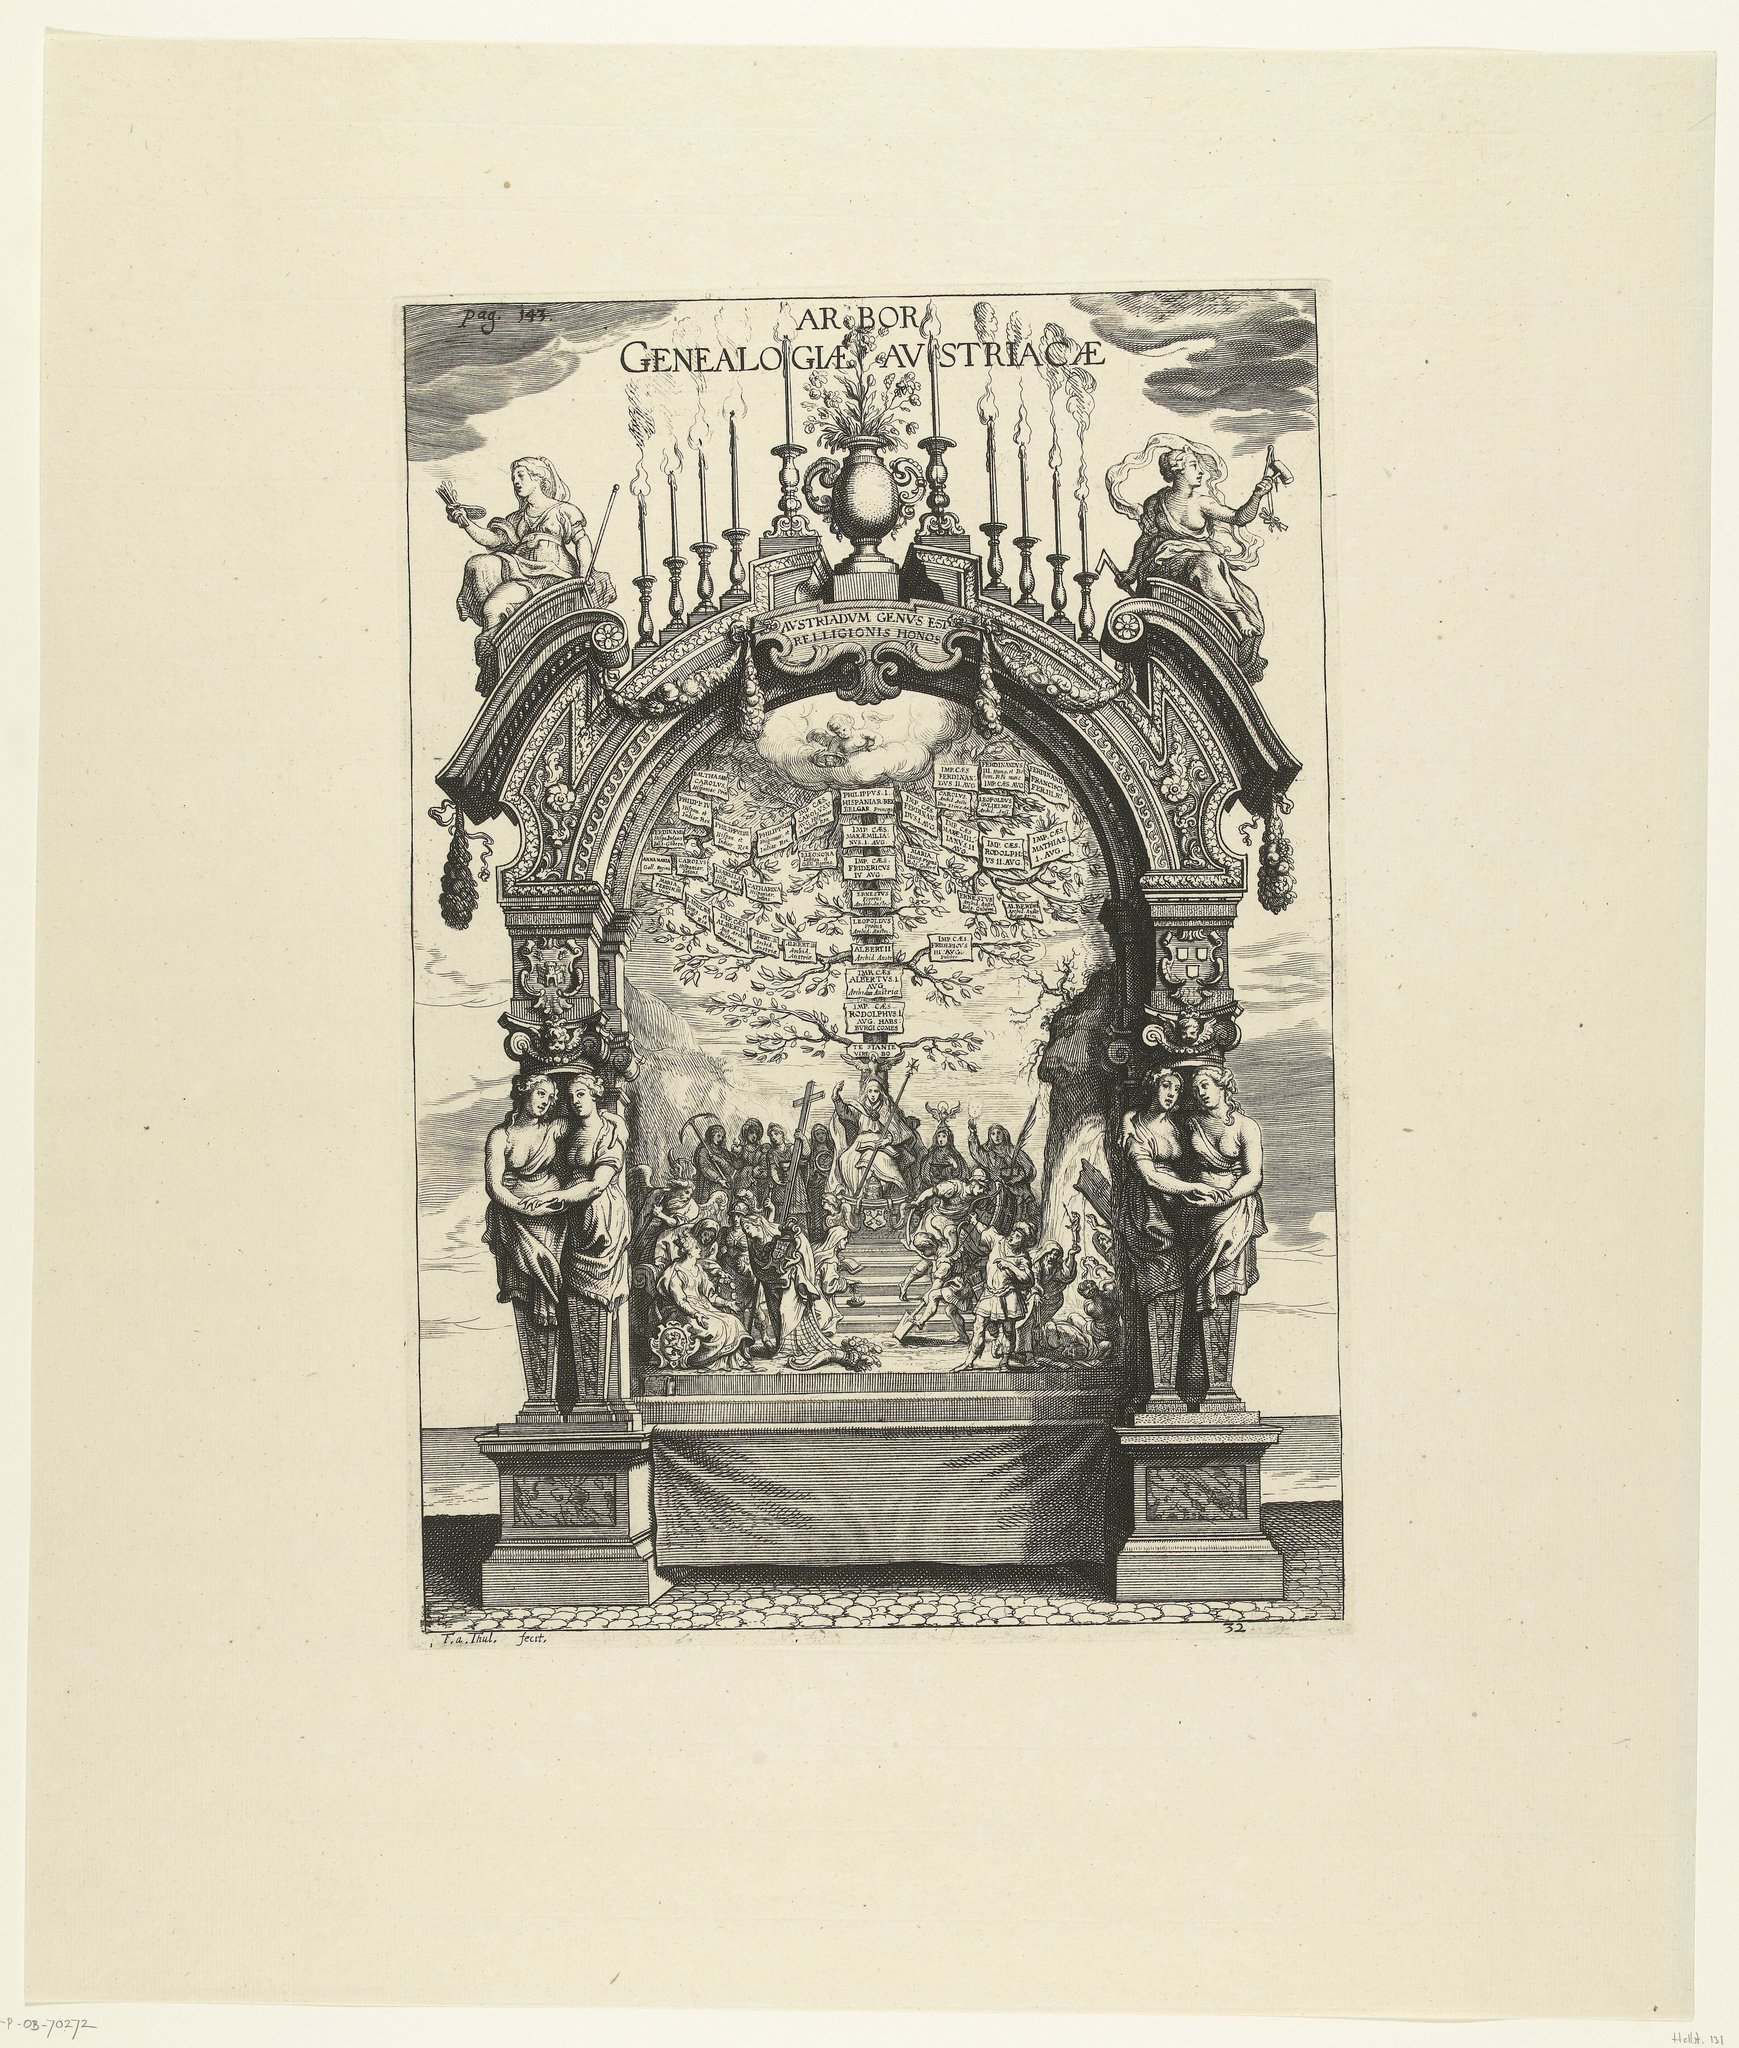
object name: print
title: Stamboom van het Oostenrijkse Huis; intocht van Ferdinand te Antwerpen in 1635 (nr. 31)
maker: theodoor van thulden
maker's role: draughtsman, painter, print maker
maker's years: 1606-1669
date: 1639-1641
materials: paper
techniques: engraving, etching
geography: southern netherlands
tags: brussels, landvoogd der zuidelijke nederlanden ferdinand van oostenrijk, 'tableau vivant', triumphal entry and public reception, pageant, 'entrée solennelle', 'joyeuse entrée', family lineage, pedigree, genealogical tree or table, antwerp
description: Stamboom van het Oostenrijkse Huis. Toneel met een tableau-vivant op de Grote Markt. Aan de voet van de stamboom zit de personificatie van de Katholieke Kerk, rechts wordt een Turkse man met een boog en een man met een afgodsbeeld naar de hel gedreven. Geheel ontworpen en uitgevoerd door de Antwerpse rederijkerskamer De Violieren. Gemerkt linksboven: pag. 143. Blad nr. 32 in een geheel van 43 platen die de uitgave van de beschrijving van de intocht van de Kardinaal Infant Ferdinand van Oostenrijk te Antwerpen op 17 april 1635 als de nieuwe landvoogd voor de Spaanse Nederlanden illustreren